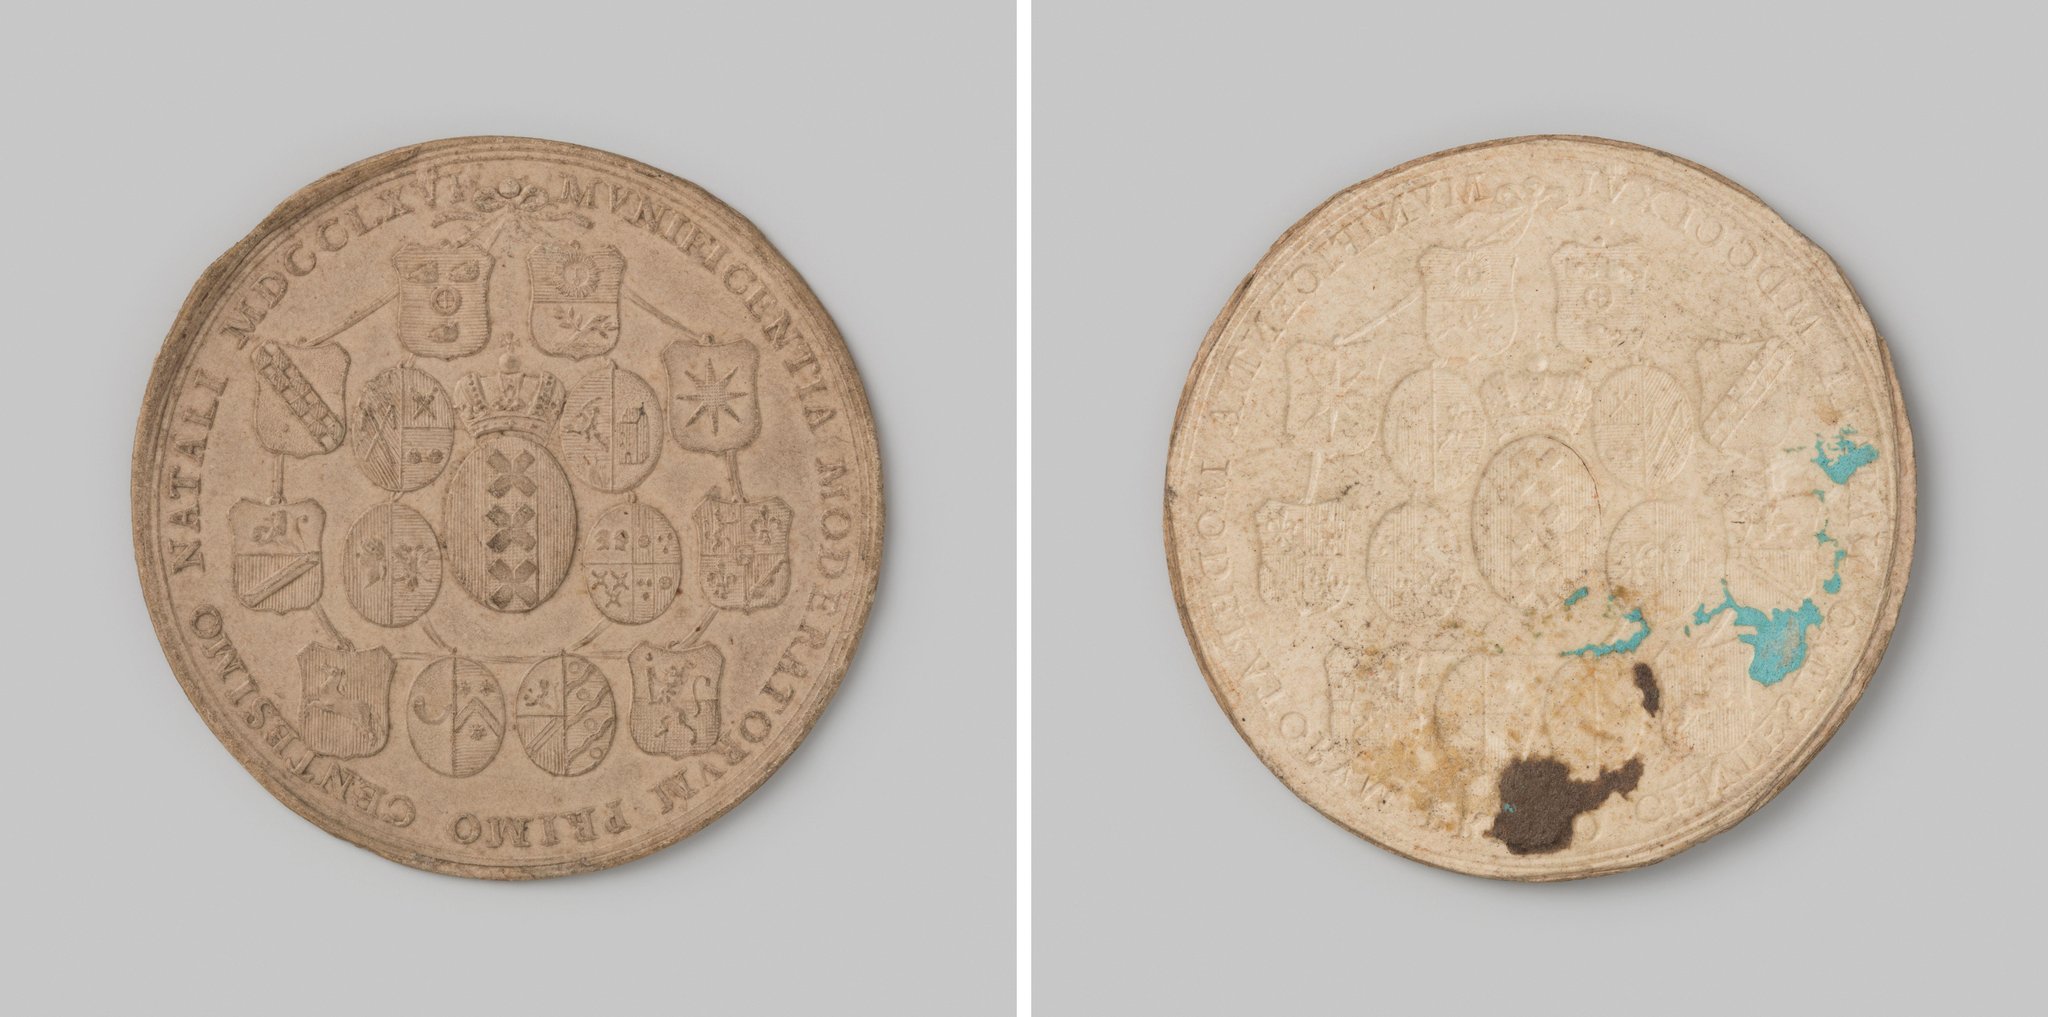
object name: history medal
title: Honderdjarig bestaan van het Aalmoezeniersweeshuis te Amsterdam 1766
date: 1766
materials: cardboard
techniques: pressing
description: Afdruk in karton van het keerzijdestempel van de penning: een gekroond wapenschild omgeven door veertien met lint samengebonden wapenschilden van regenten en regentessen van het weeshuis, met omschrift.